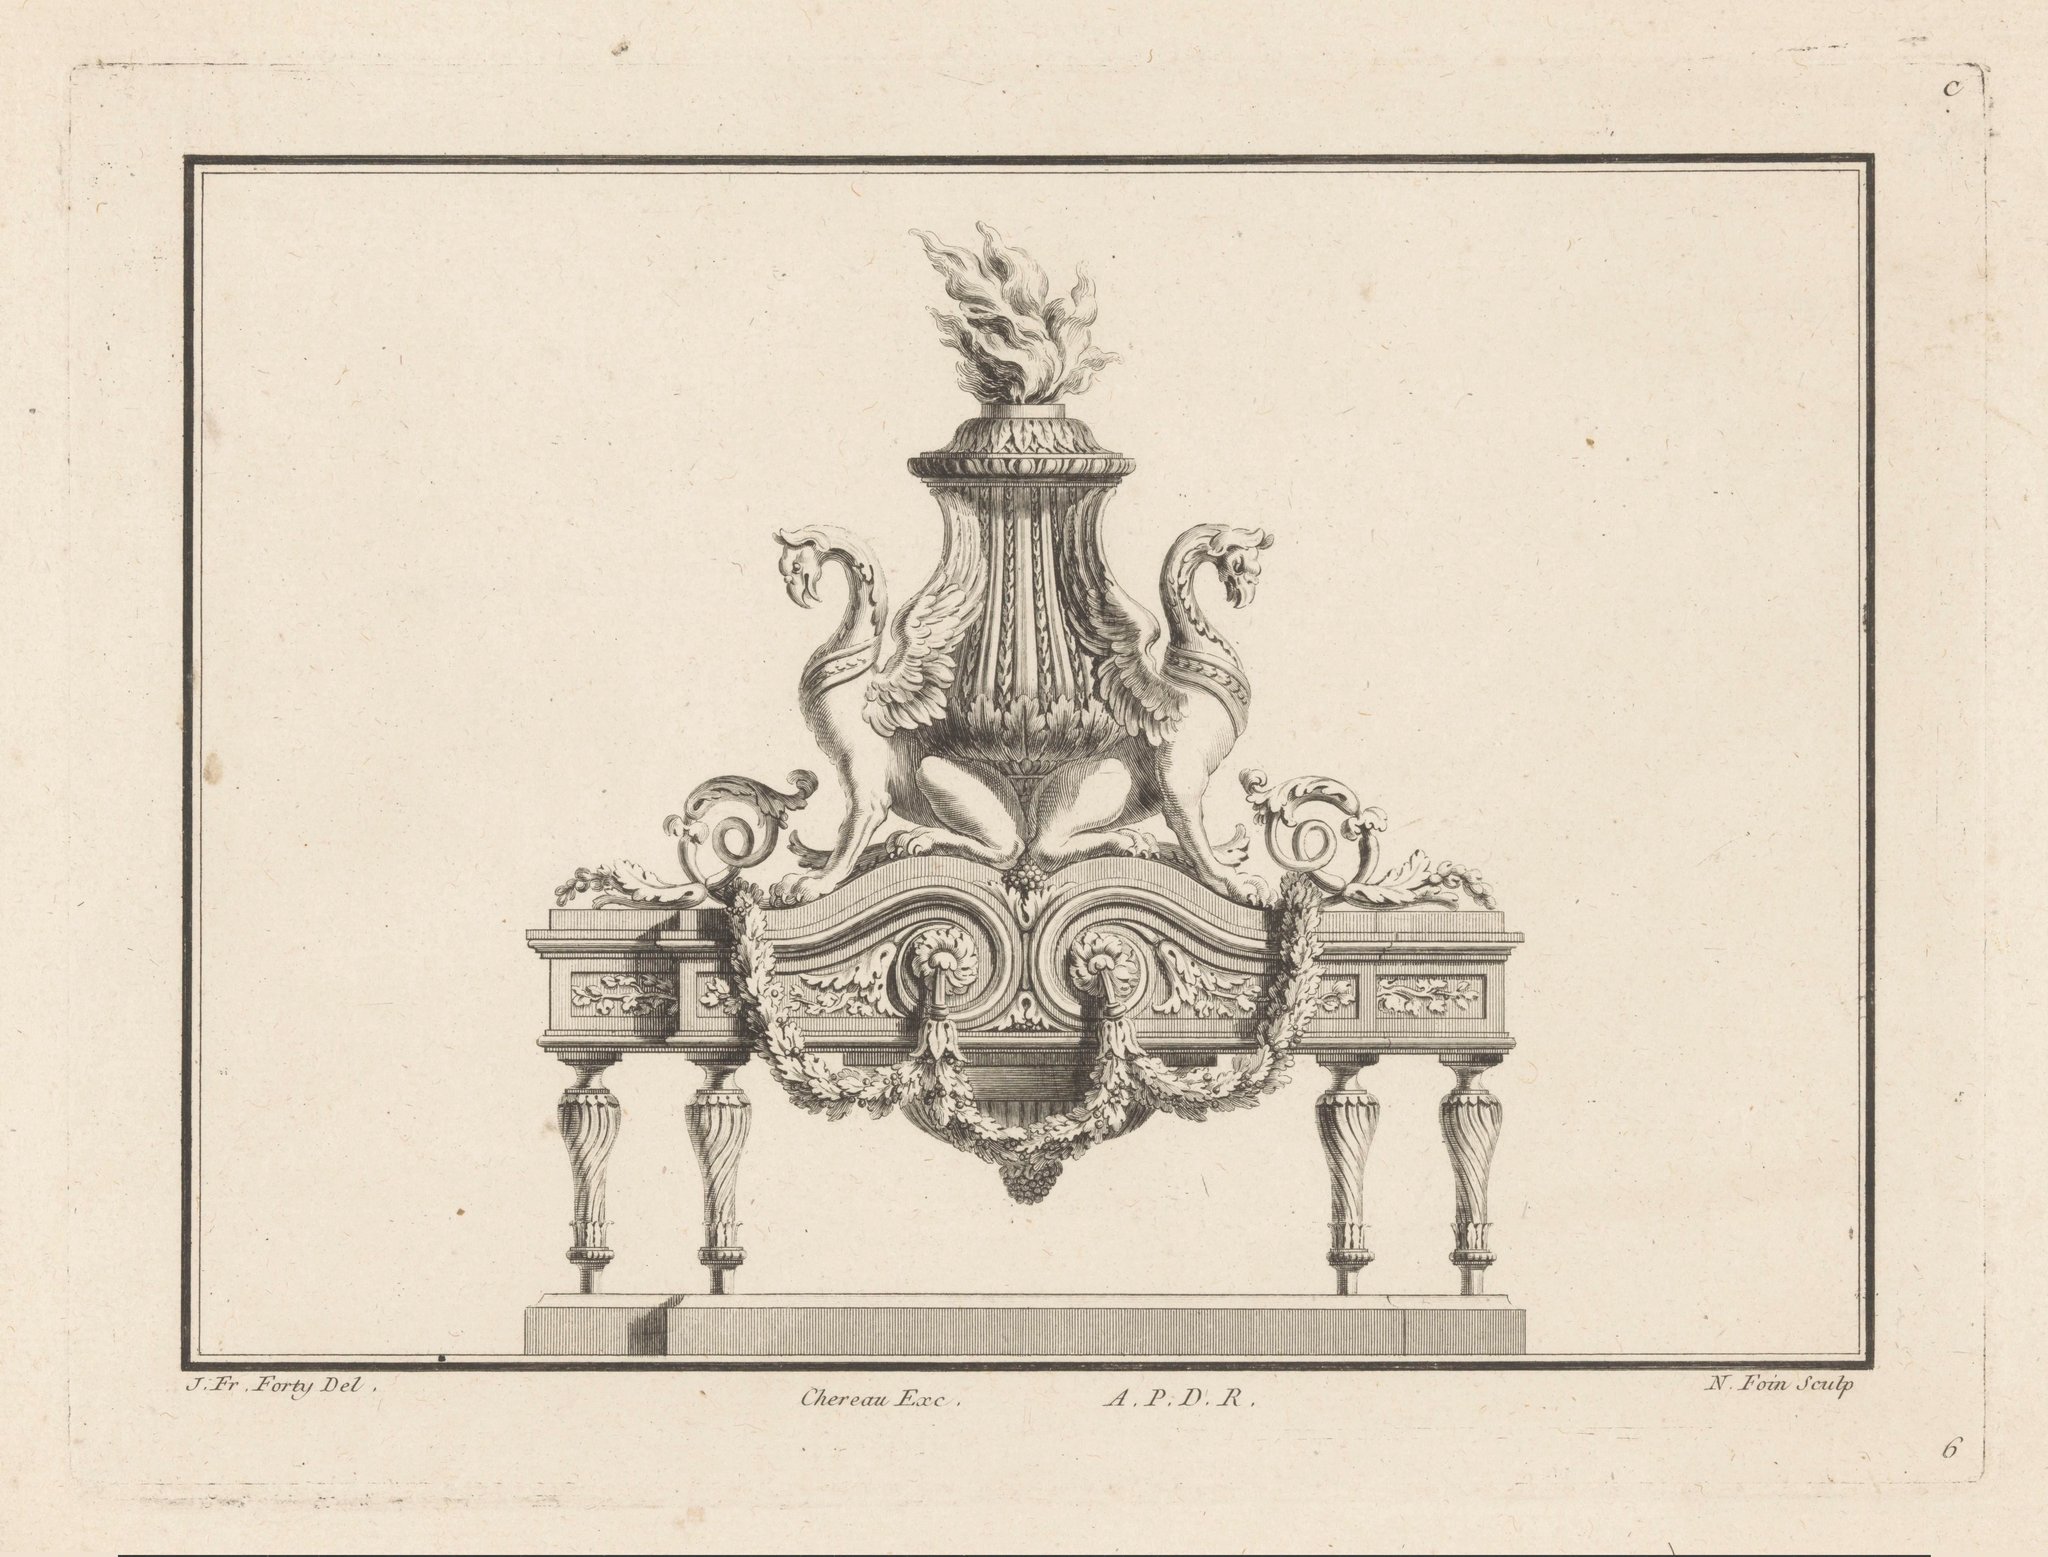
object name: print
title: Vuurbok met griffioenen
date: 1775-1790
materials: paper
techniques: engraving, etching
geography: paris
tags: griffin (lion/eagle); 'griffo' (ripa), andiron, fire-dog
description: Een geornamenteerde vuurbok met griffioenen aan weerszijden van een vaas met vuur.